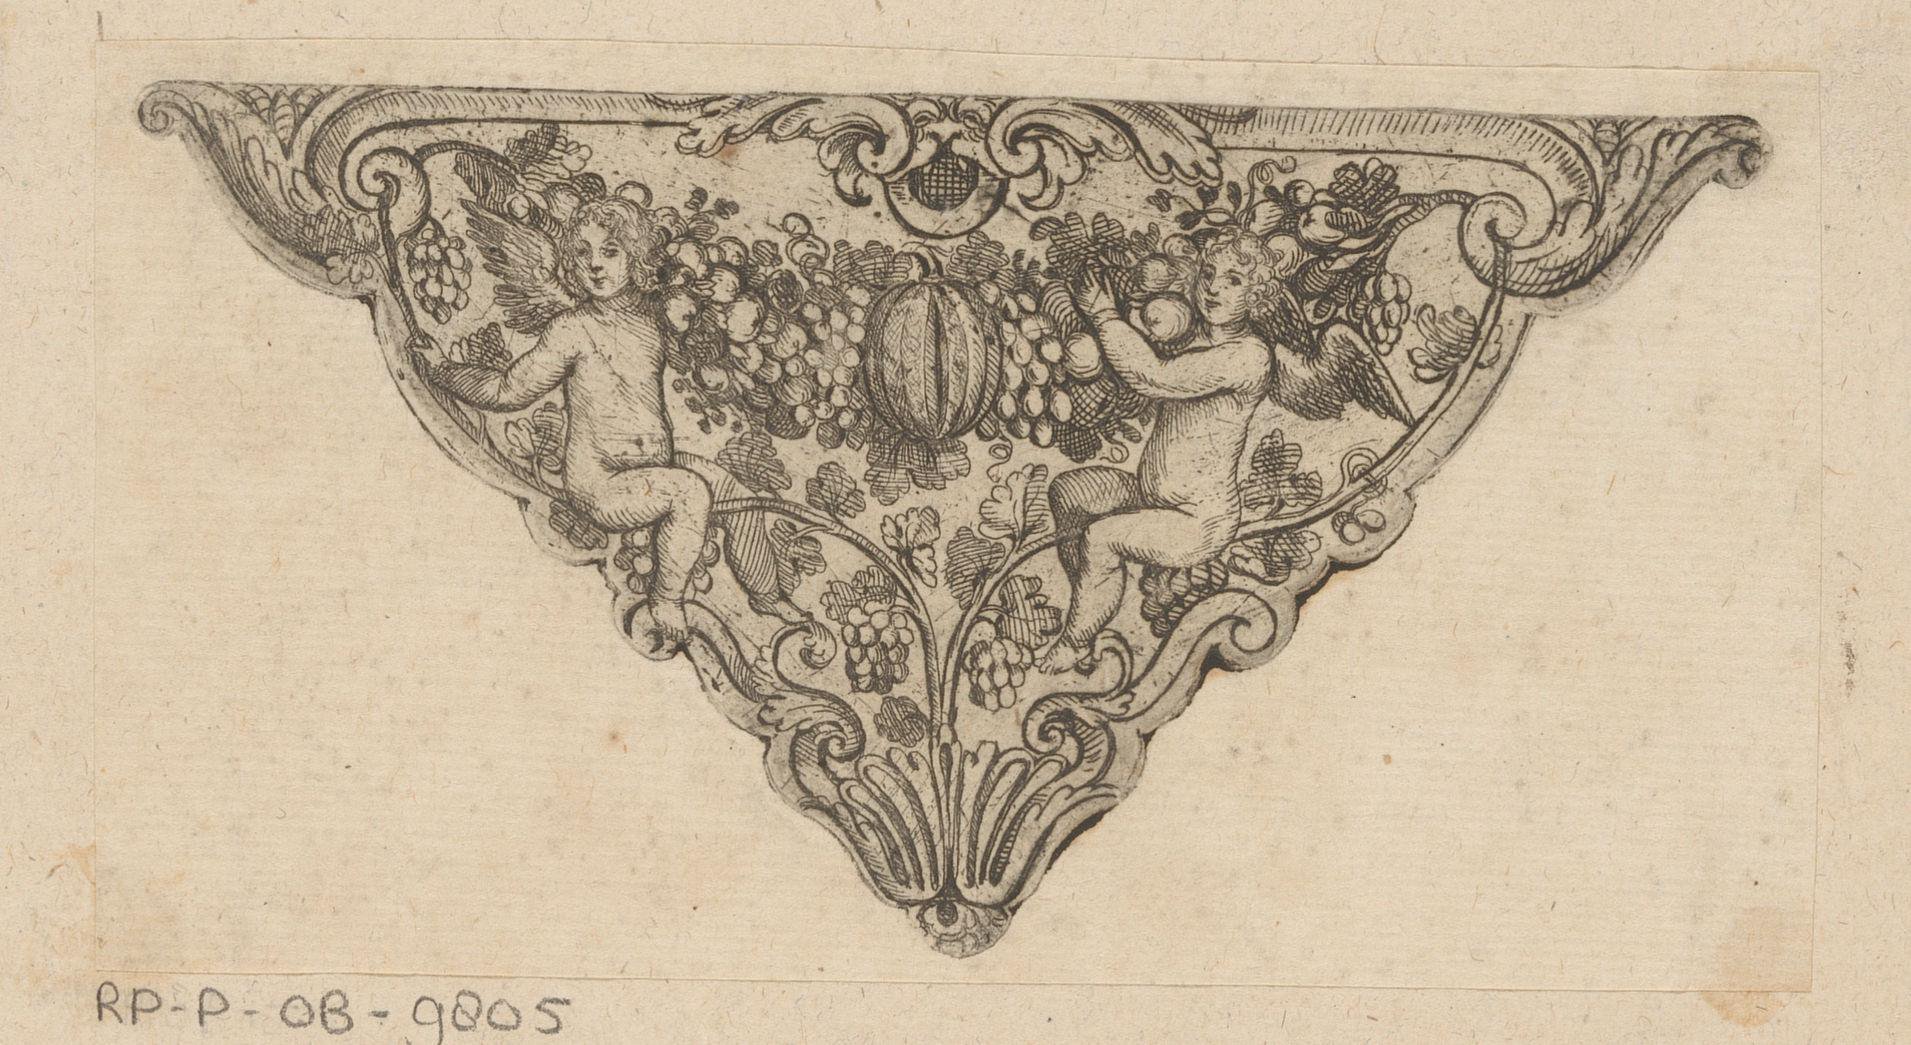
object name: book illustration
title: Cul-de-lampe met putti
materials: paper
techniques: etching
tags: ornaments ~ art, vignette, cupids: 'amores', 'amoretti', 'putti'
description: Prent uit: Bardin, Philippe. Le Triomphe De Son Altesse Charles IIII (...). Nancy: Poirel, Dominique, Charlot Anthoine en Charlot Claude, 1664.